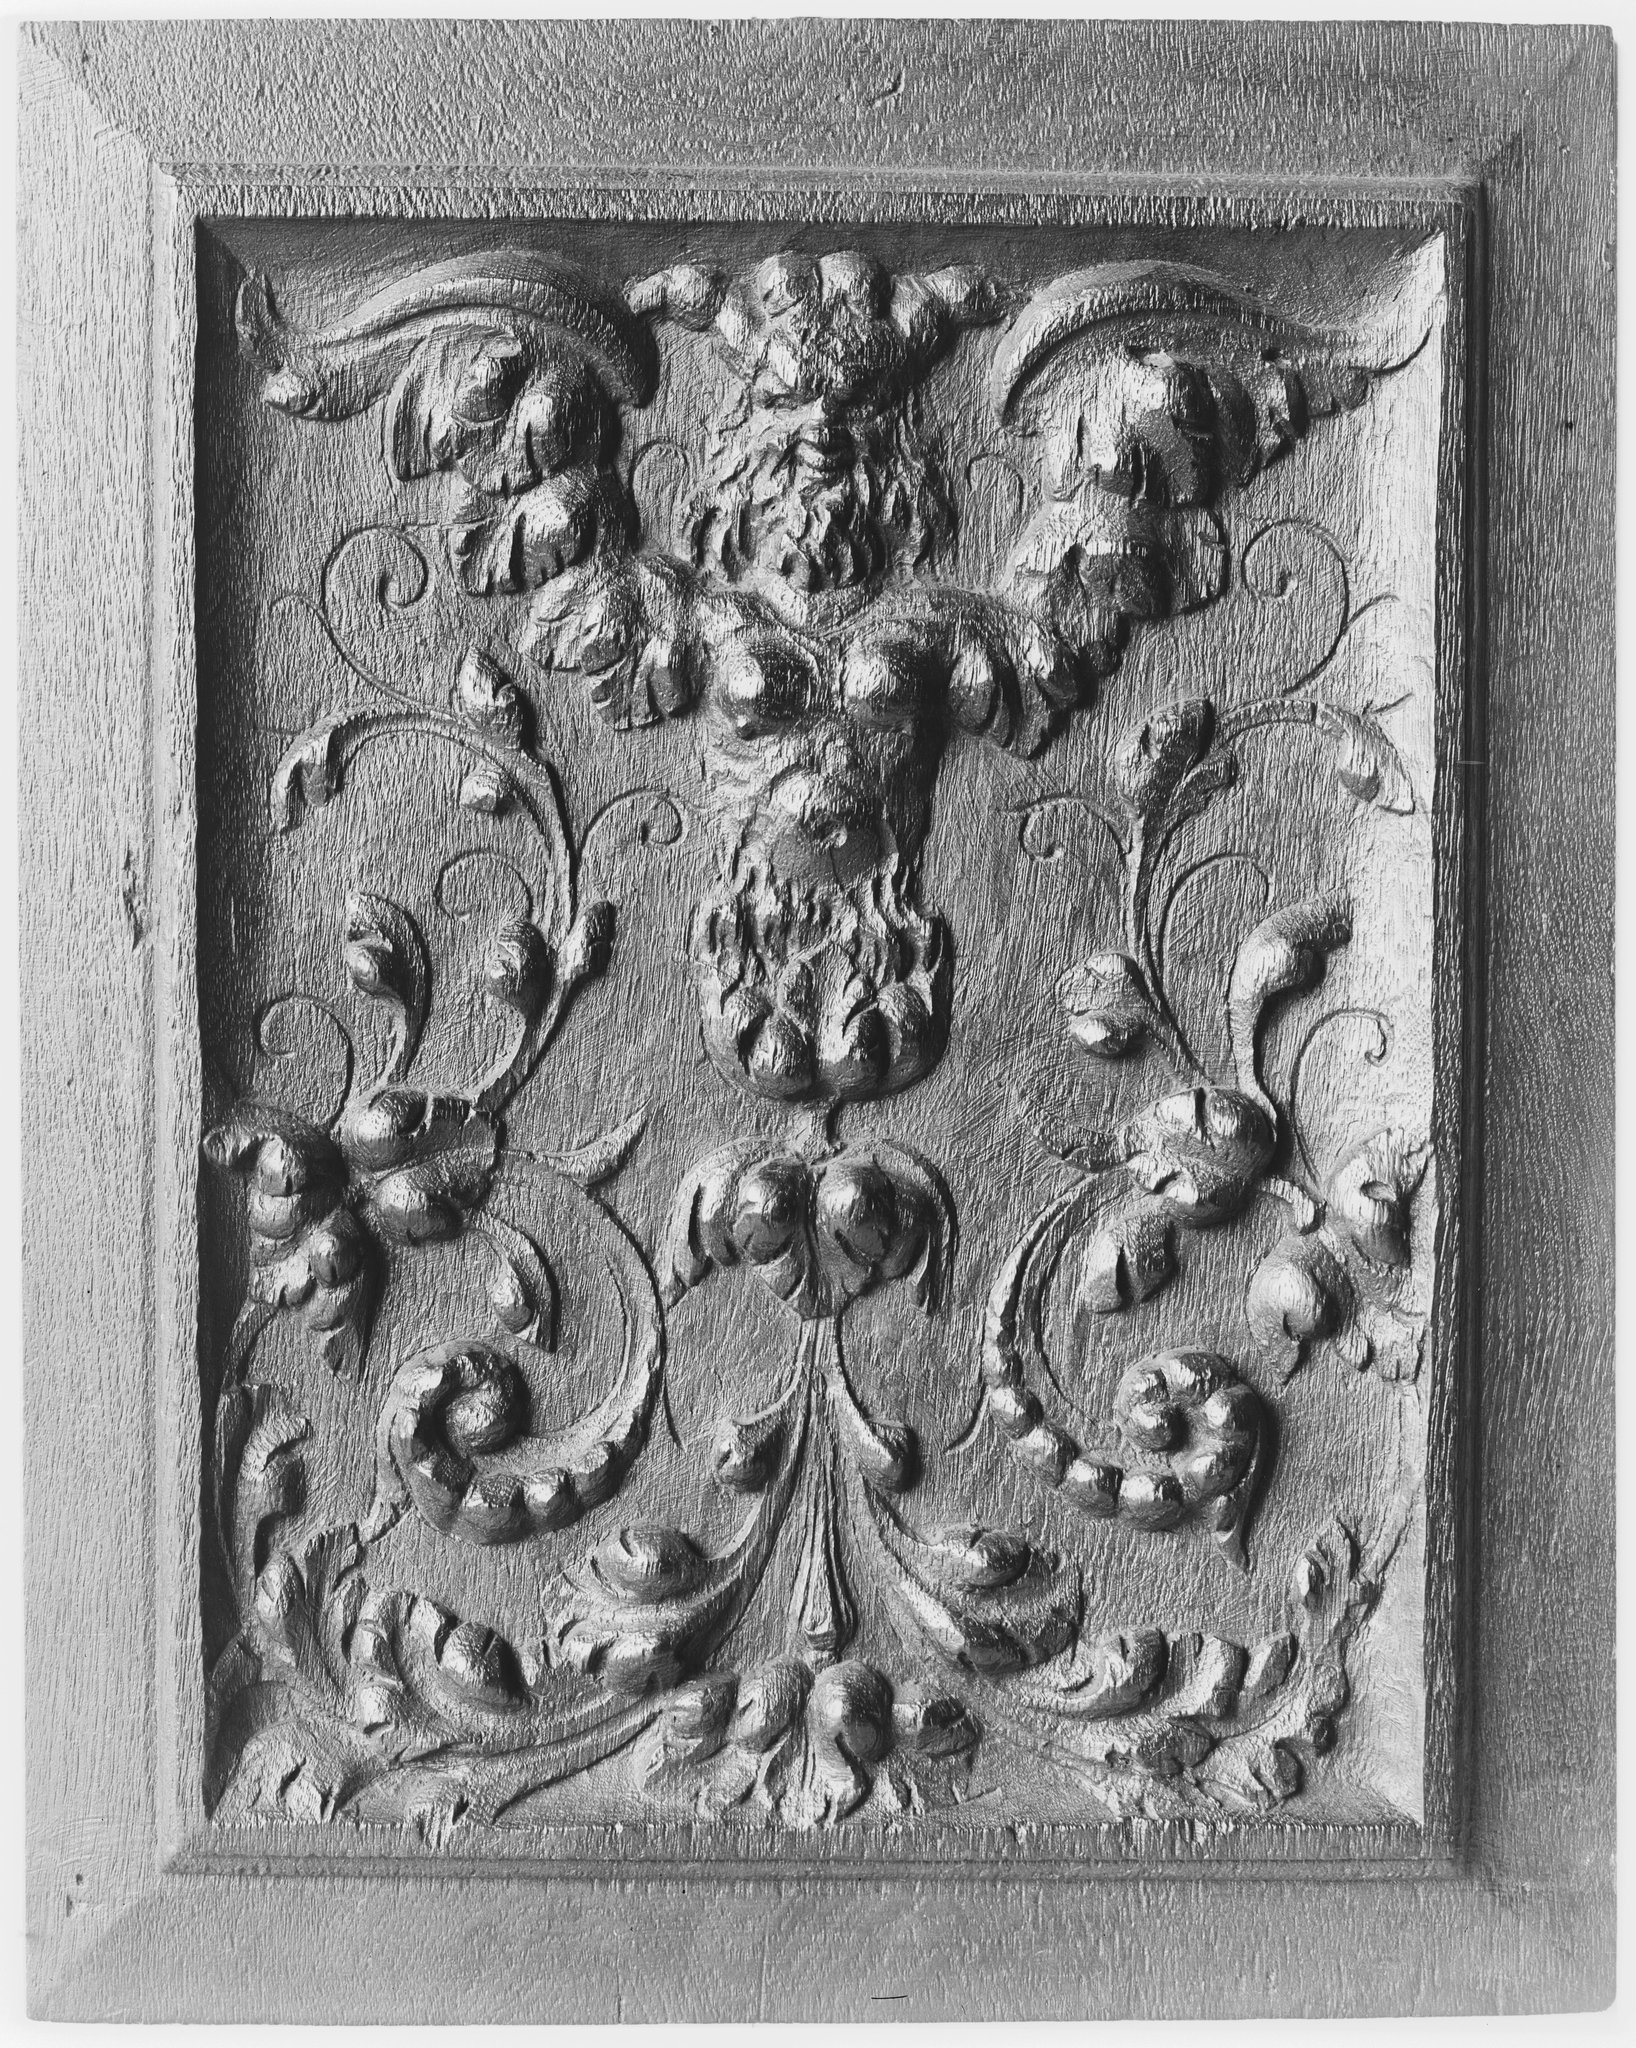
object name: panel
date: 1551-1600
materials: wood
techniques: carving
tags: satyrs